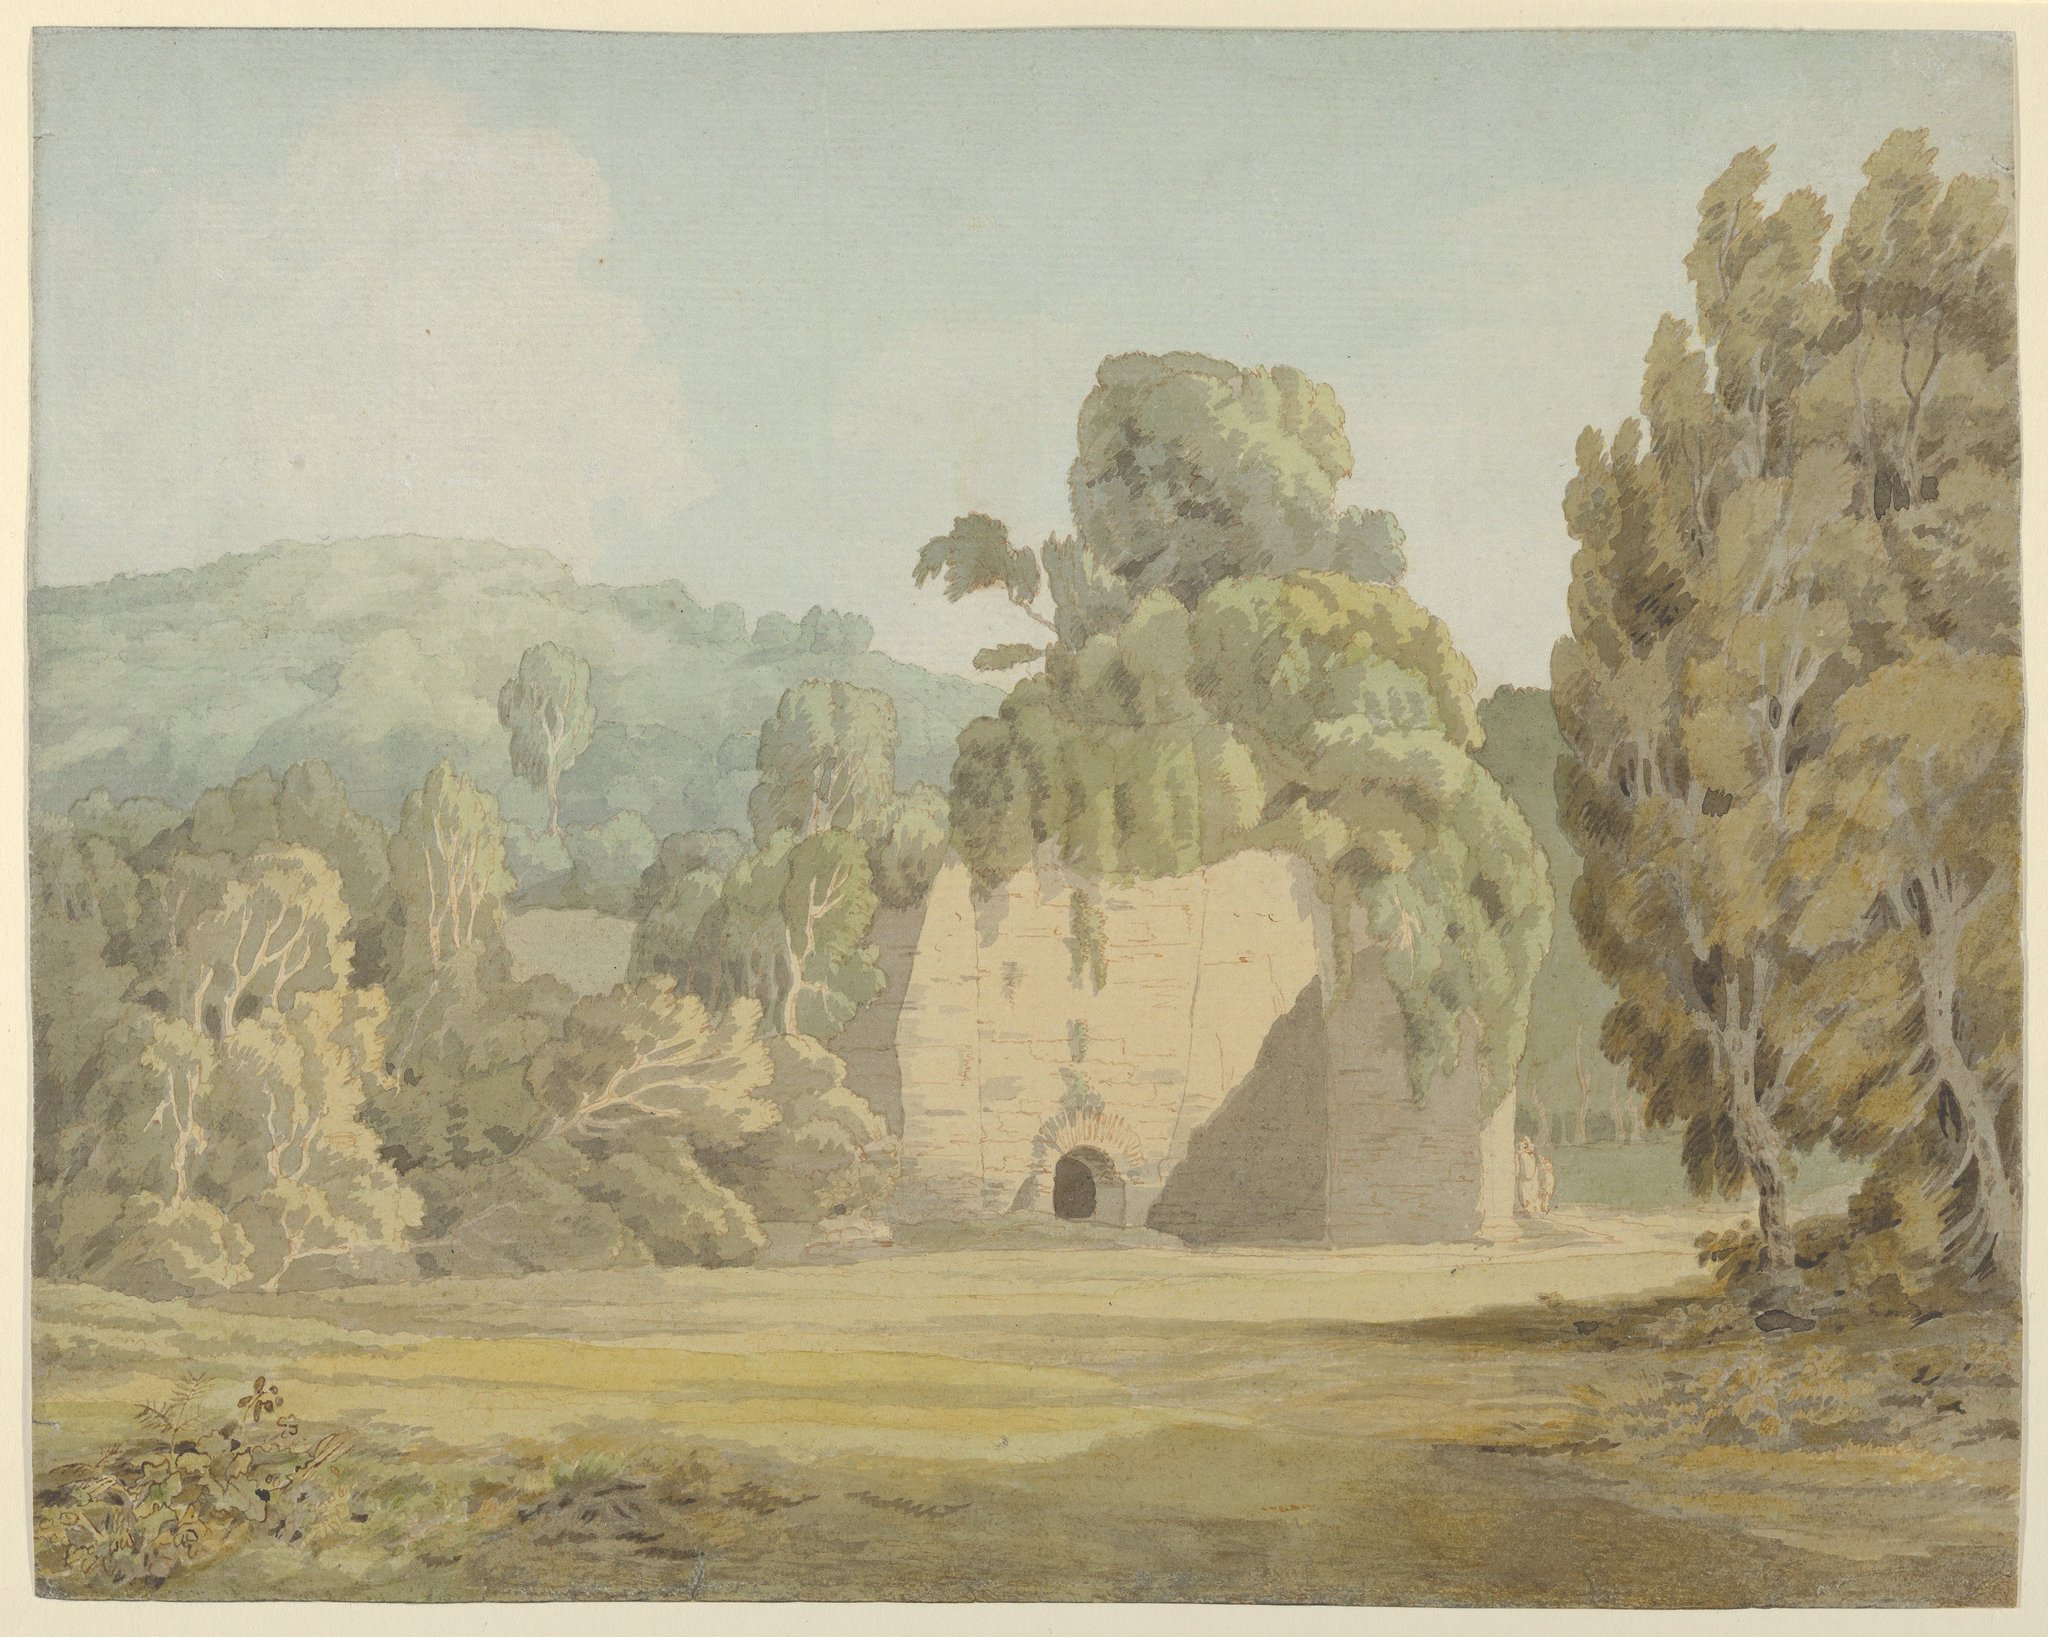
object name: drawing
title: An ivy covered ruin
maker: francis towne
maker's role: artist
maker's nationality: british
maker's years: 1739-1816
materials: graphite, ink, watercolor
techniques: pen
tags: ruins,trees